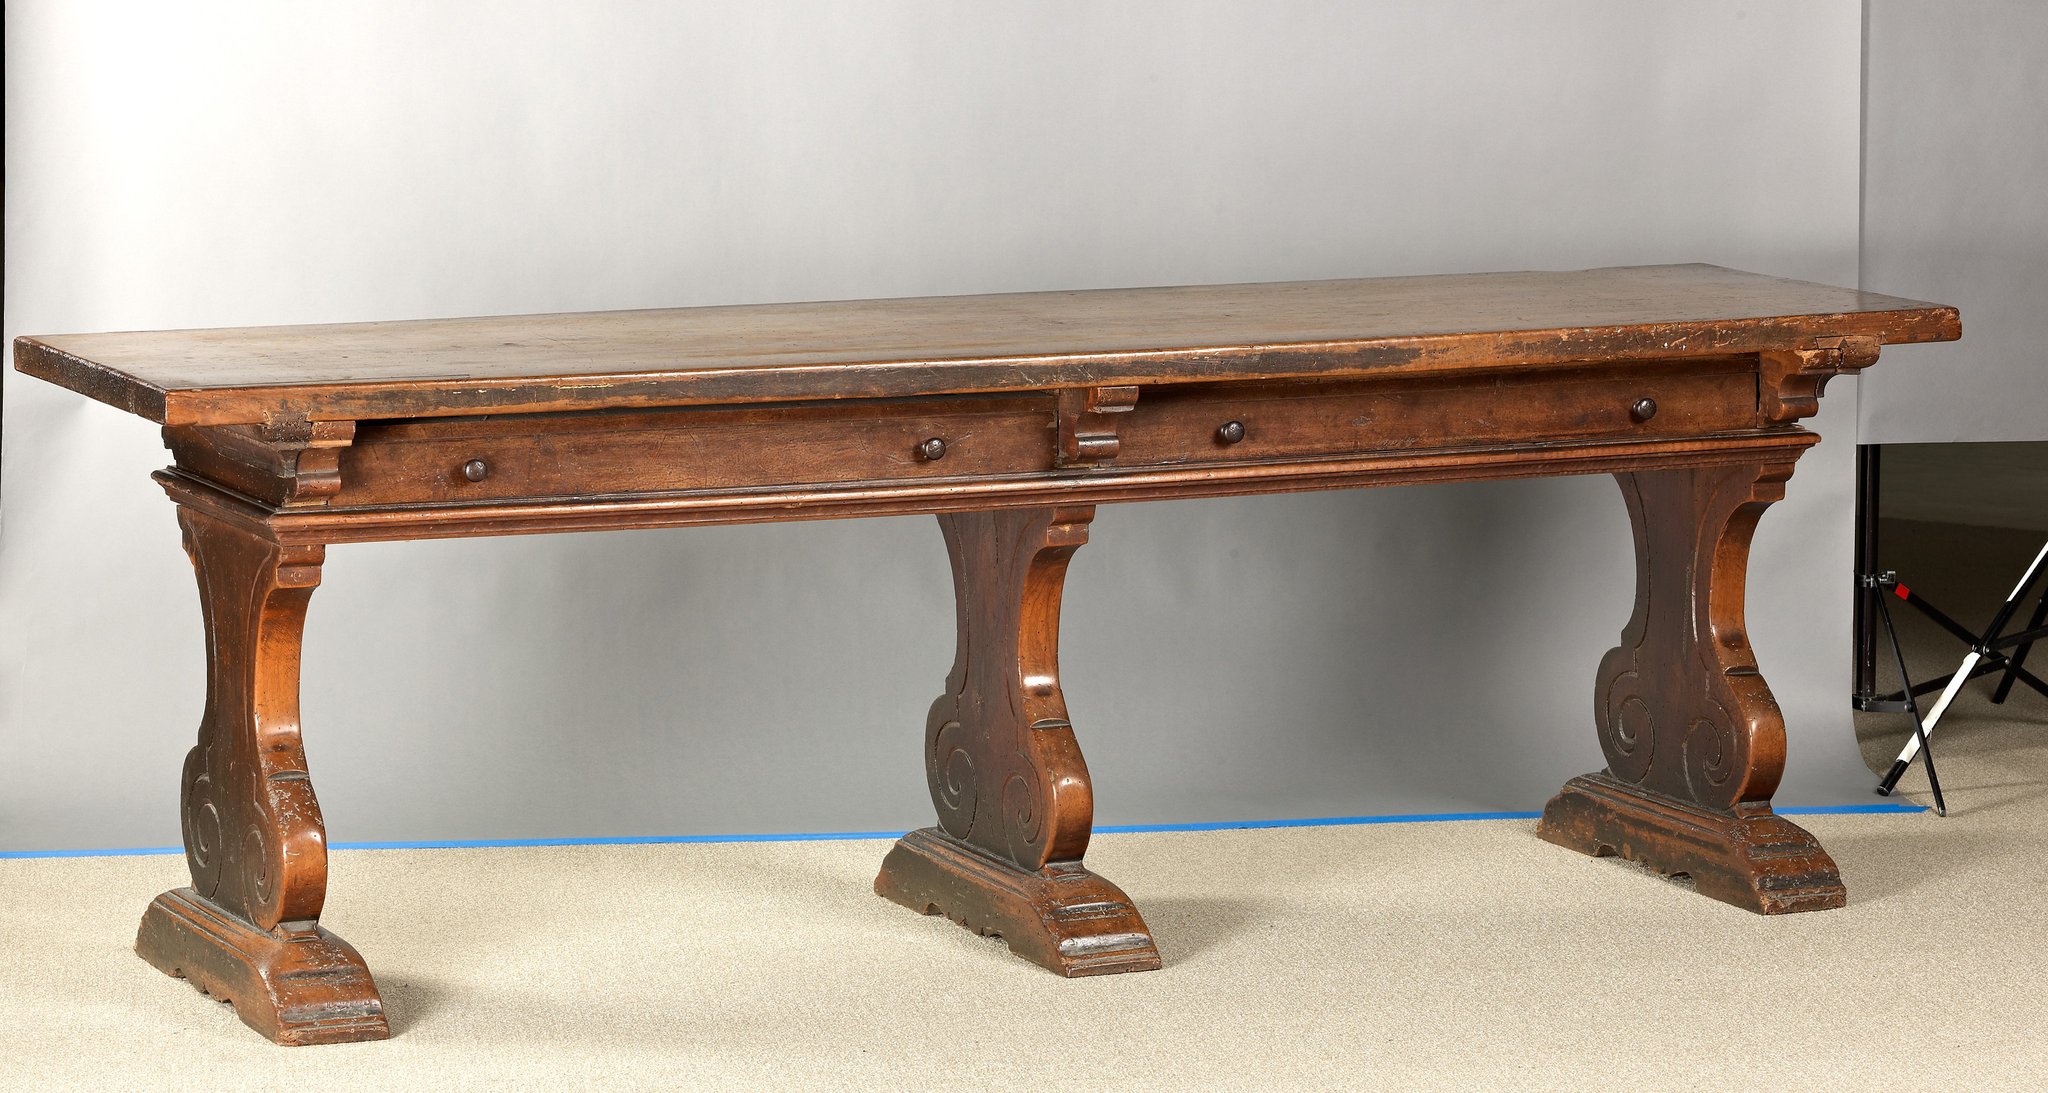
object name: table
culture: italian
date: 1801-1900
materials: wood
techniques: carving